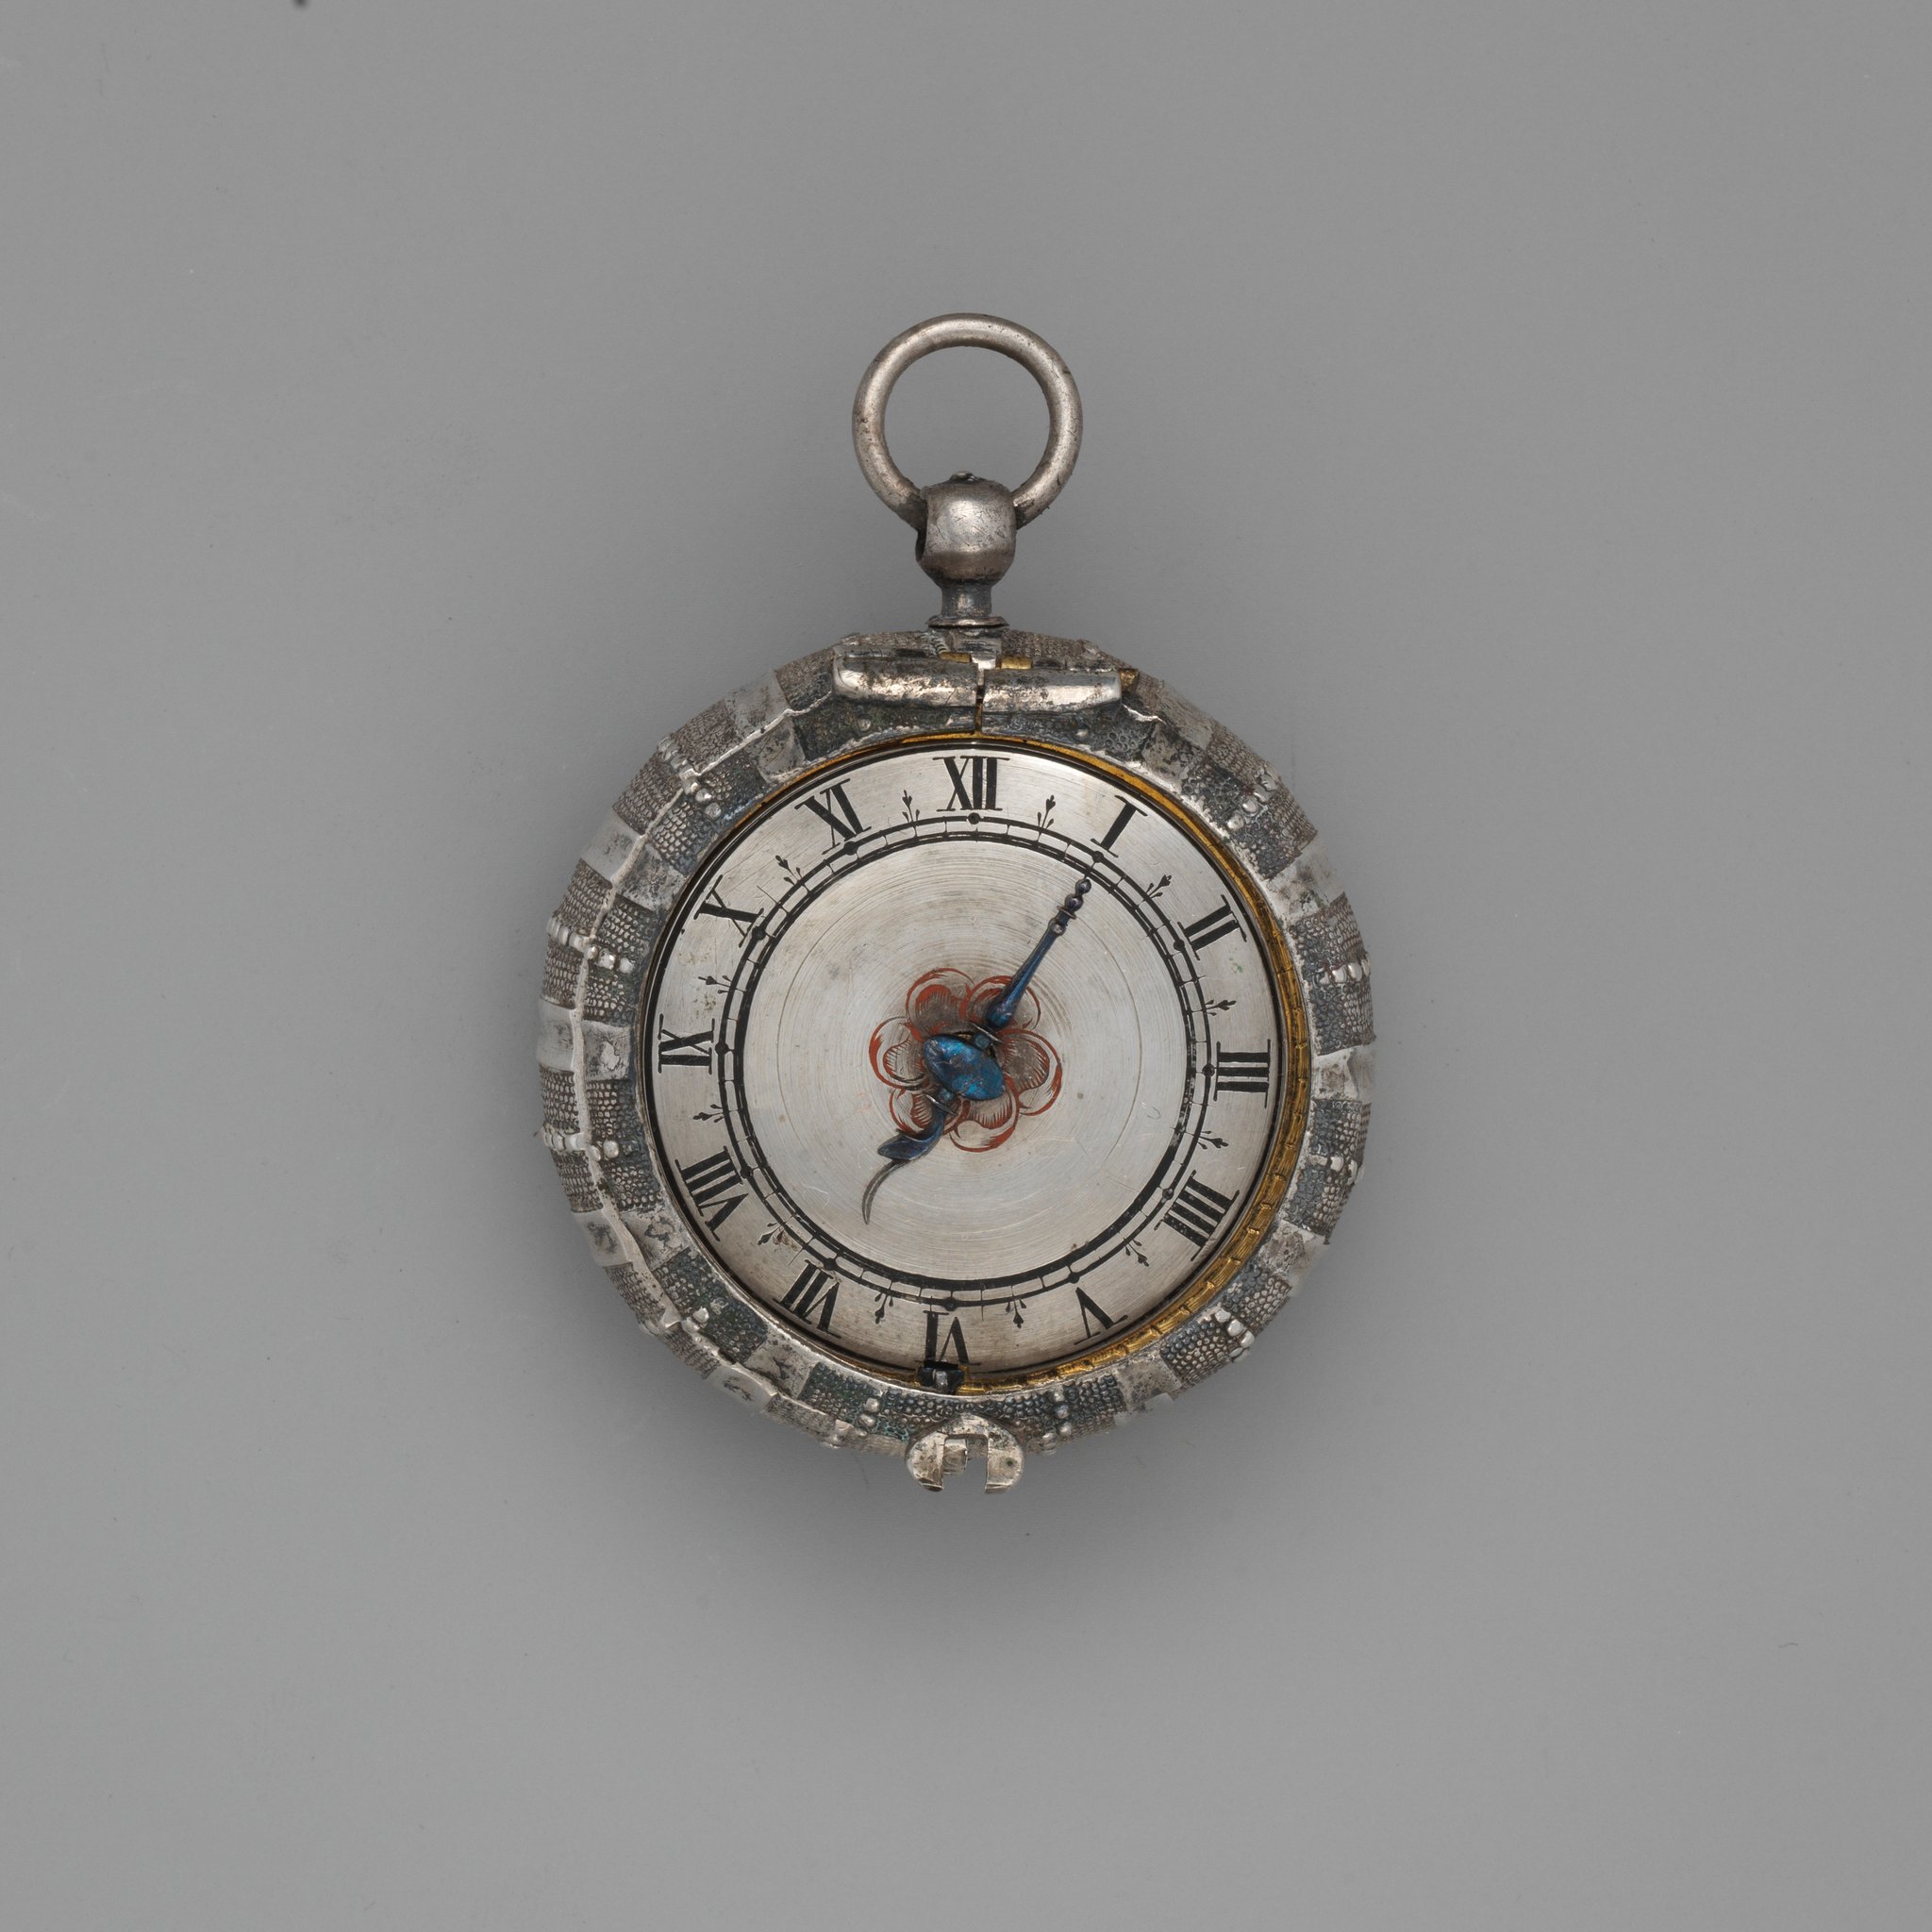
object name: watch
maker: jaques collomb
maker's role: maker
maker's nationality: swiss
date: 1651-1675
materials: leather, silver